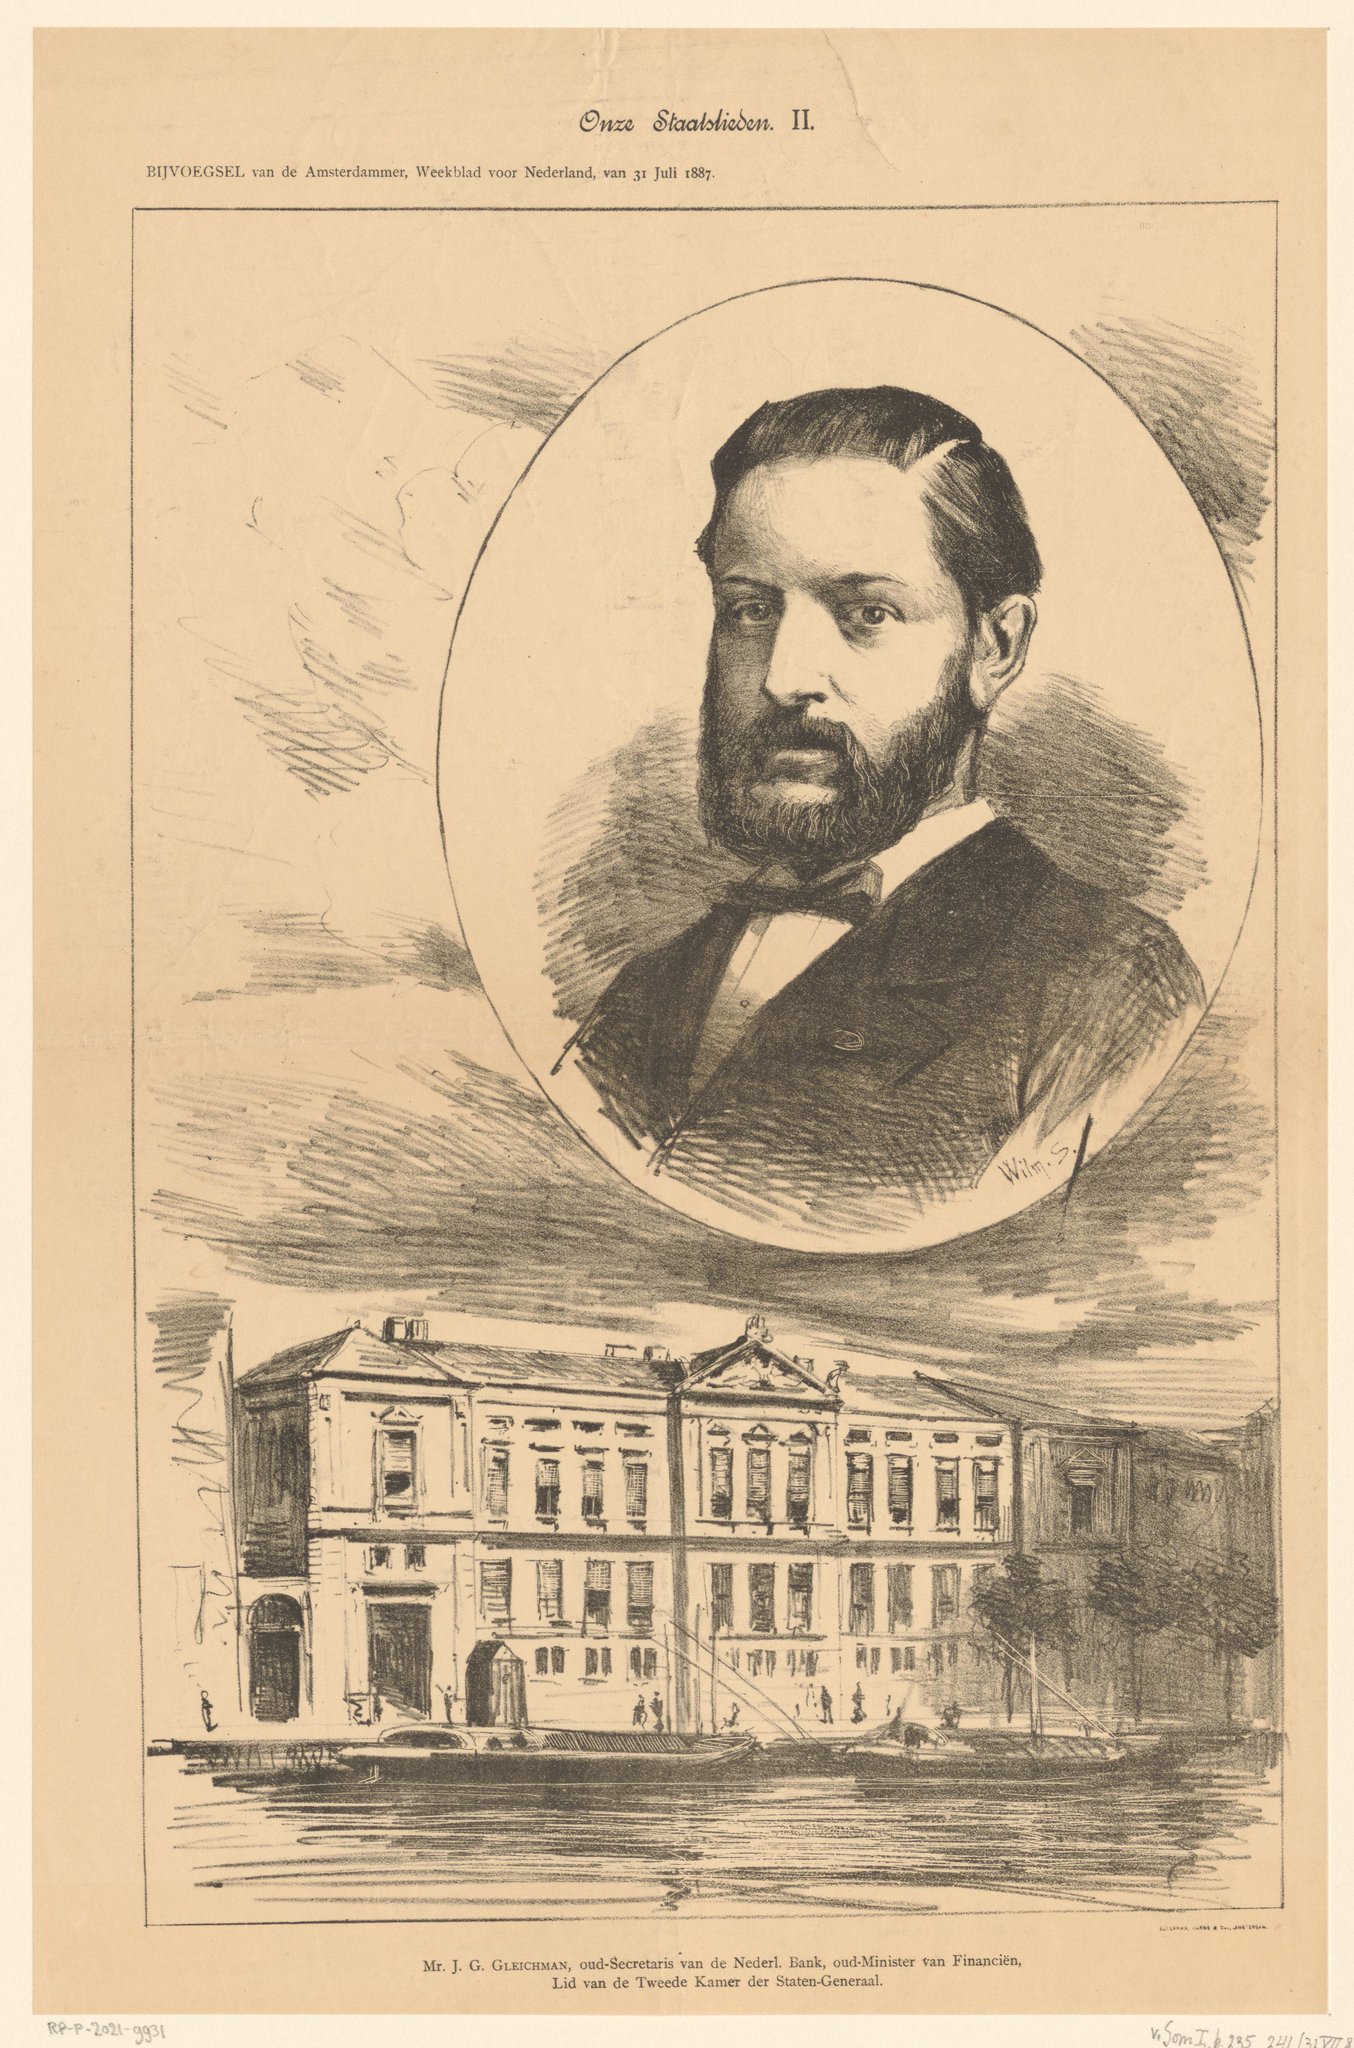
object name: print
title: Portret van Johan Georg Gleichman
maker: willem steelink (ii)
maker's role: draughtsman, print maker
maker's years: 1856-1928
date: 1887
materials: paper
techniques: lithograph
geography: amsterdam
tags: the hague, politician, historical persons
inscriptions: collector's mark: Lugt 2228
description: Prent uit een bijvoegsel van de Amsterdammer, 31 juli 1887.